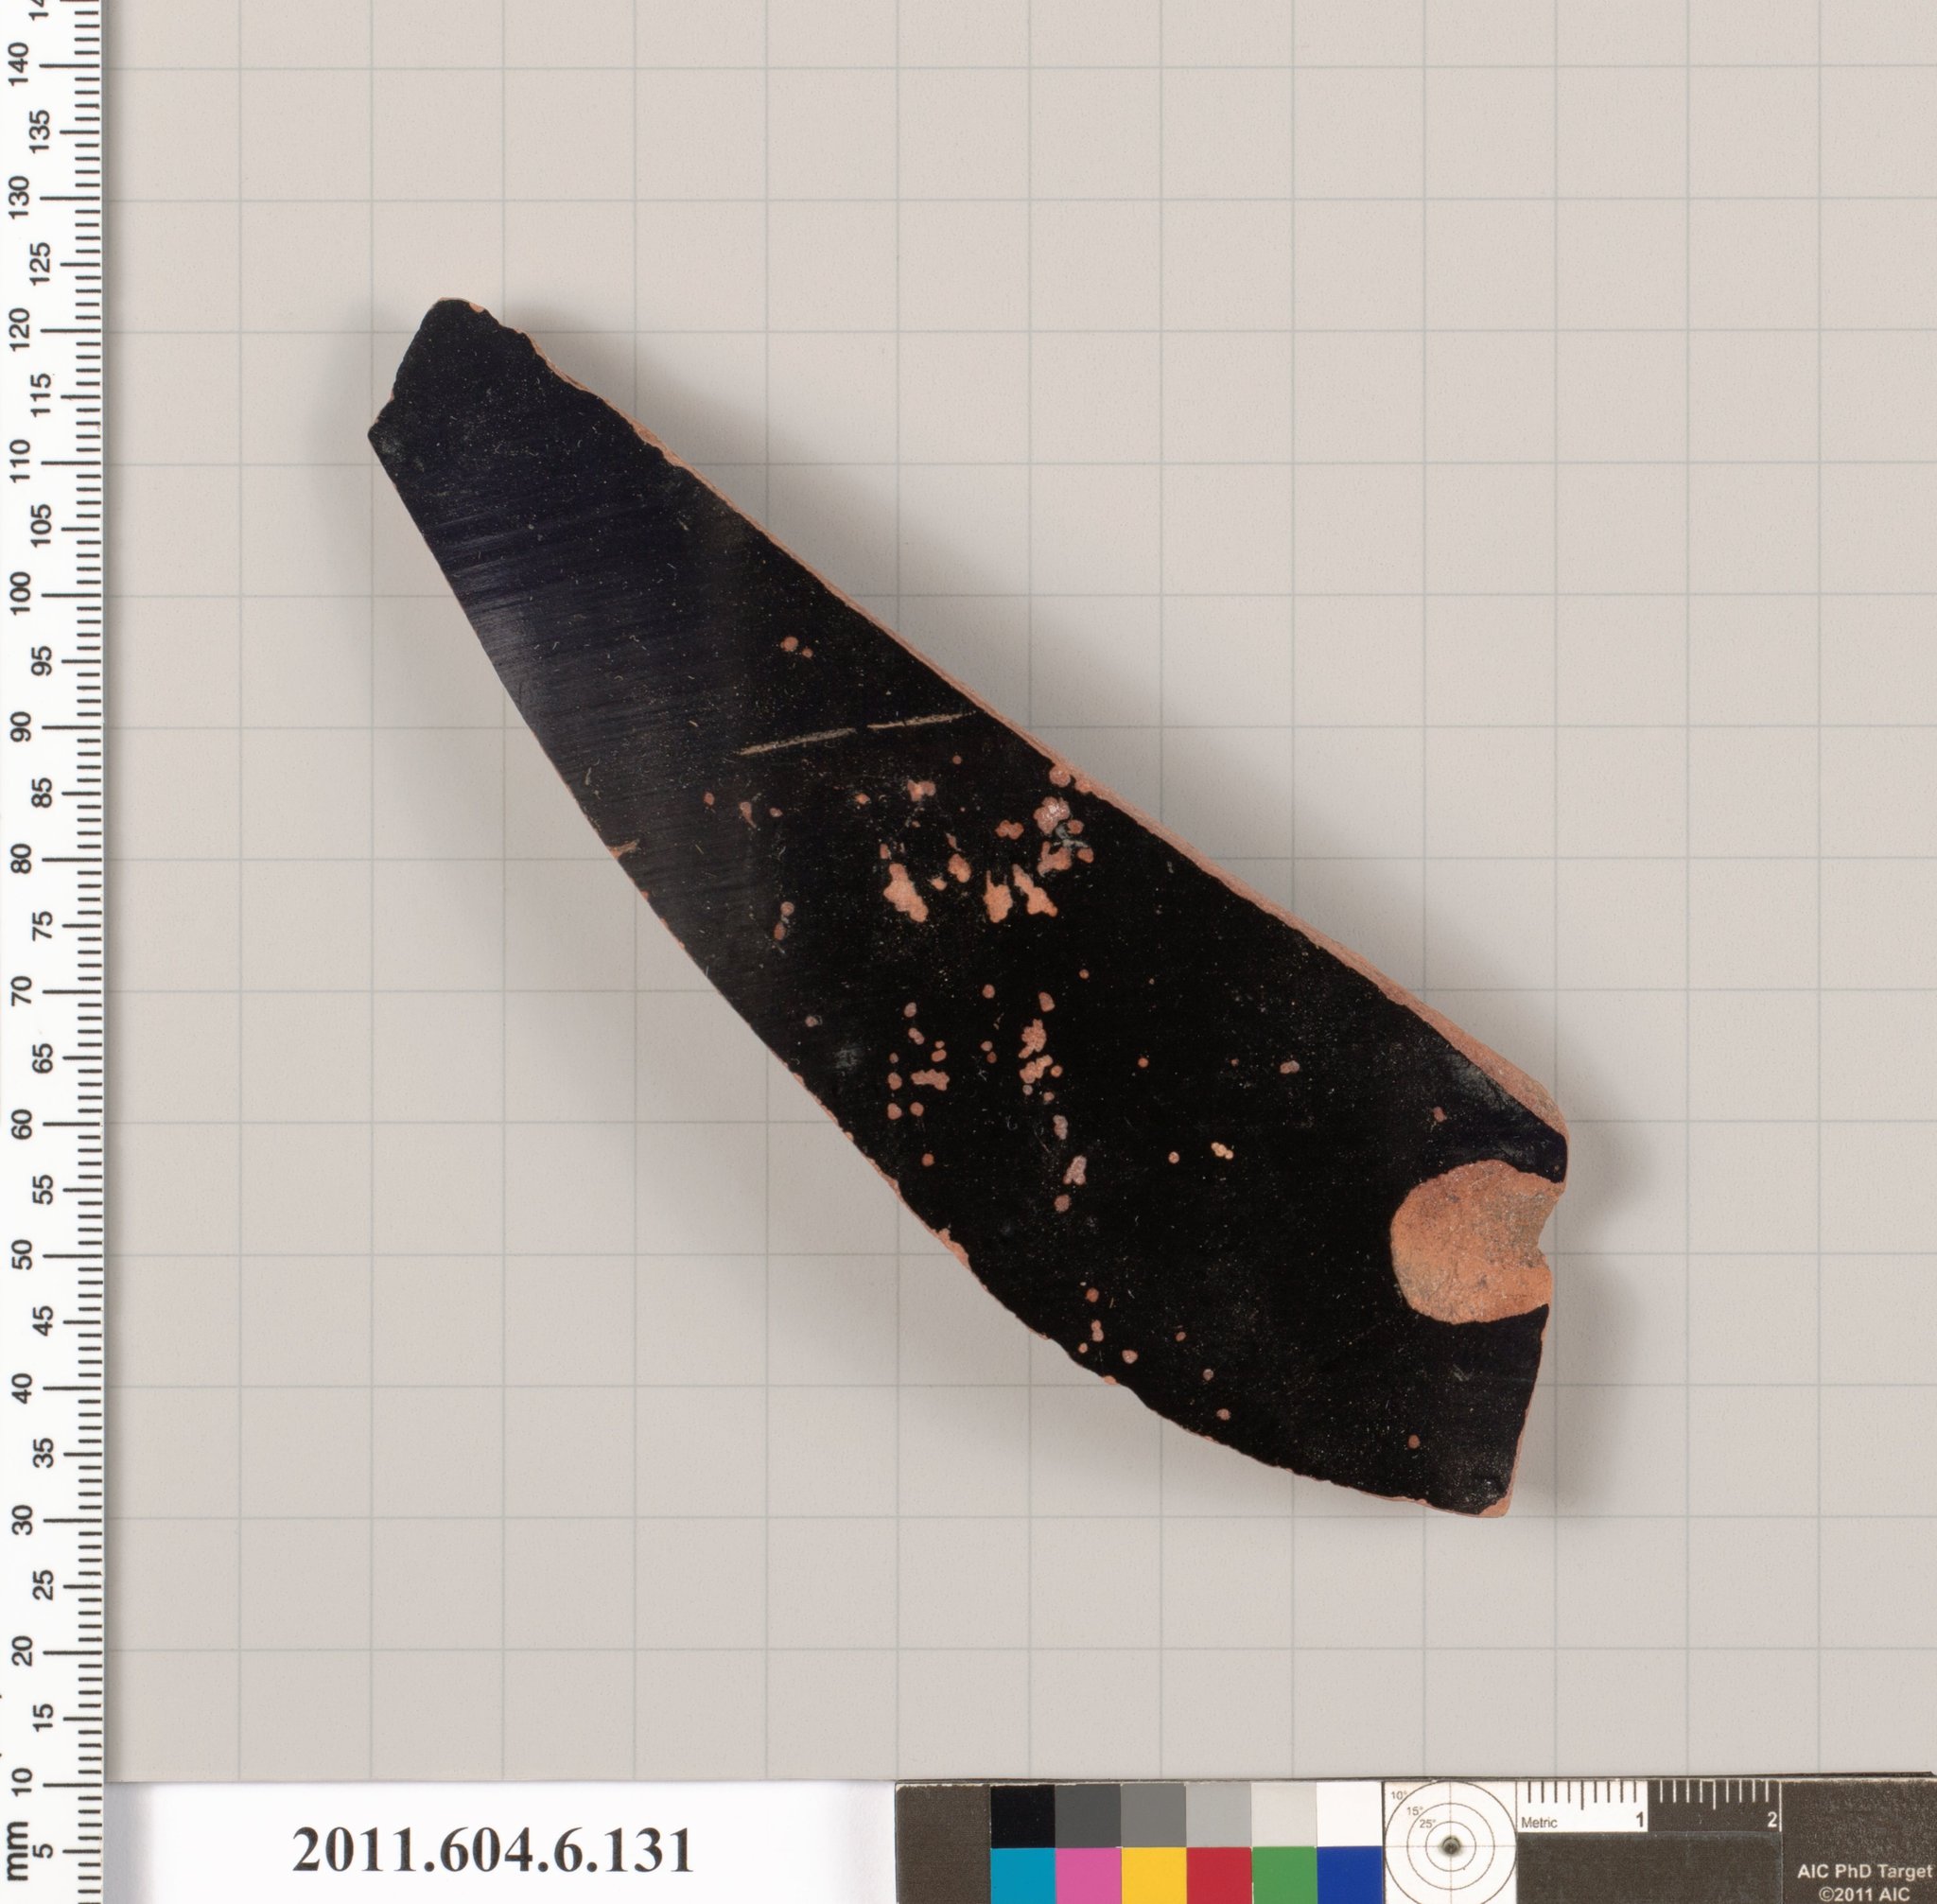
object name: undetermined open shape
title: Terracotta fragment of an open shape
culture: greek, attic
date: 600-401 BCE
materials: terracotta